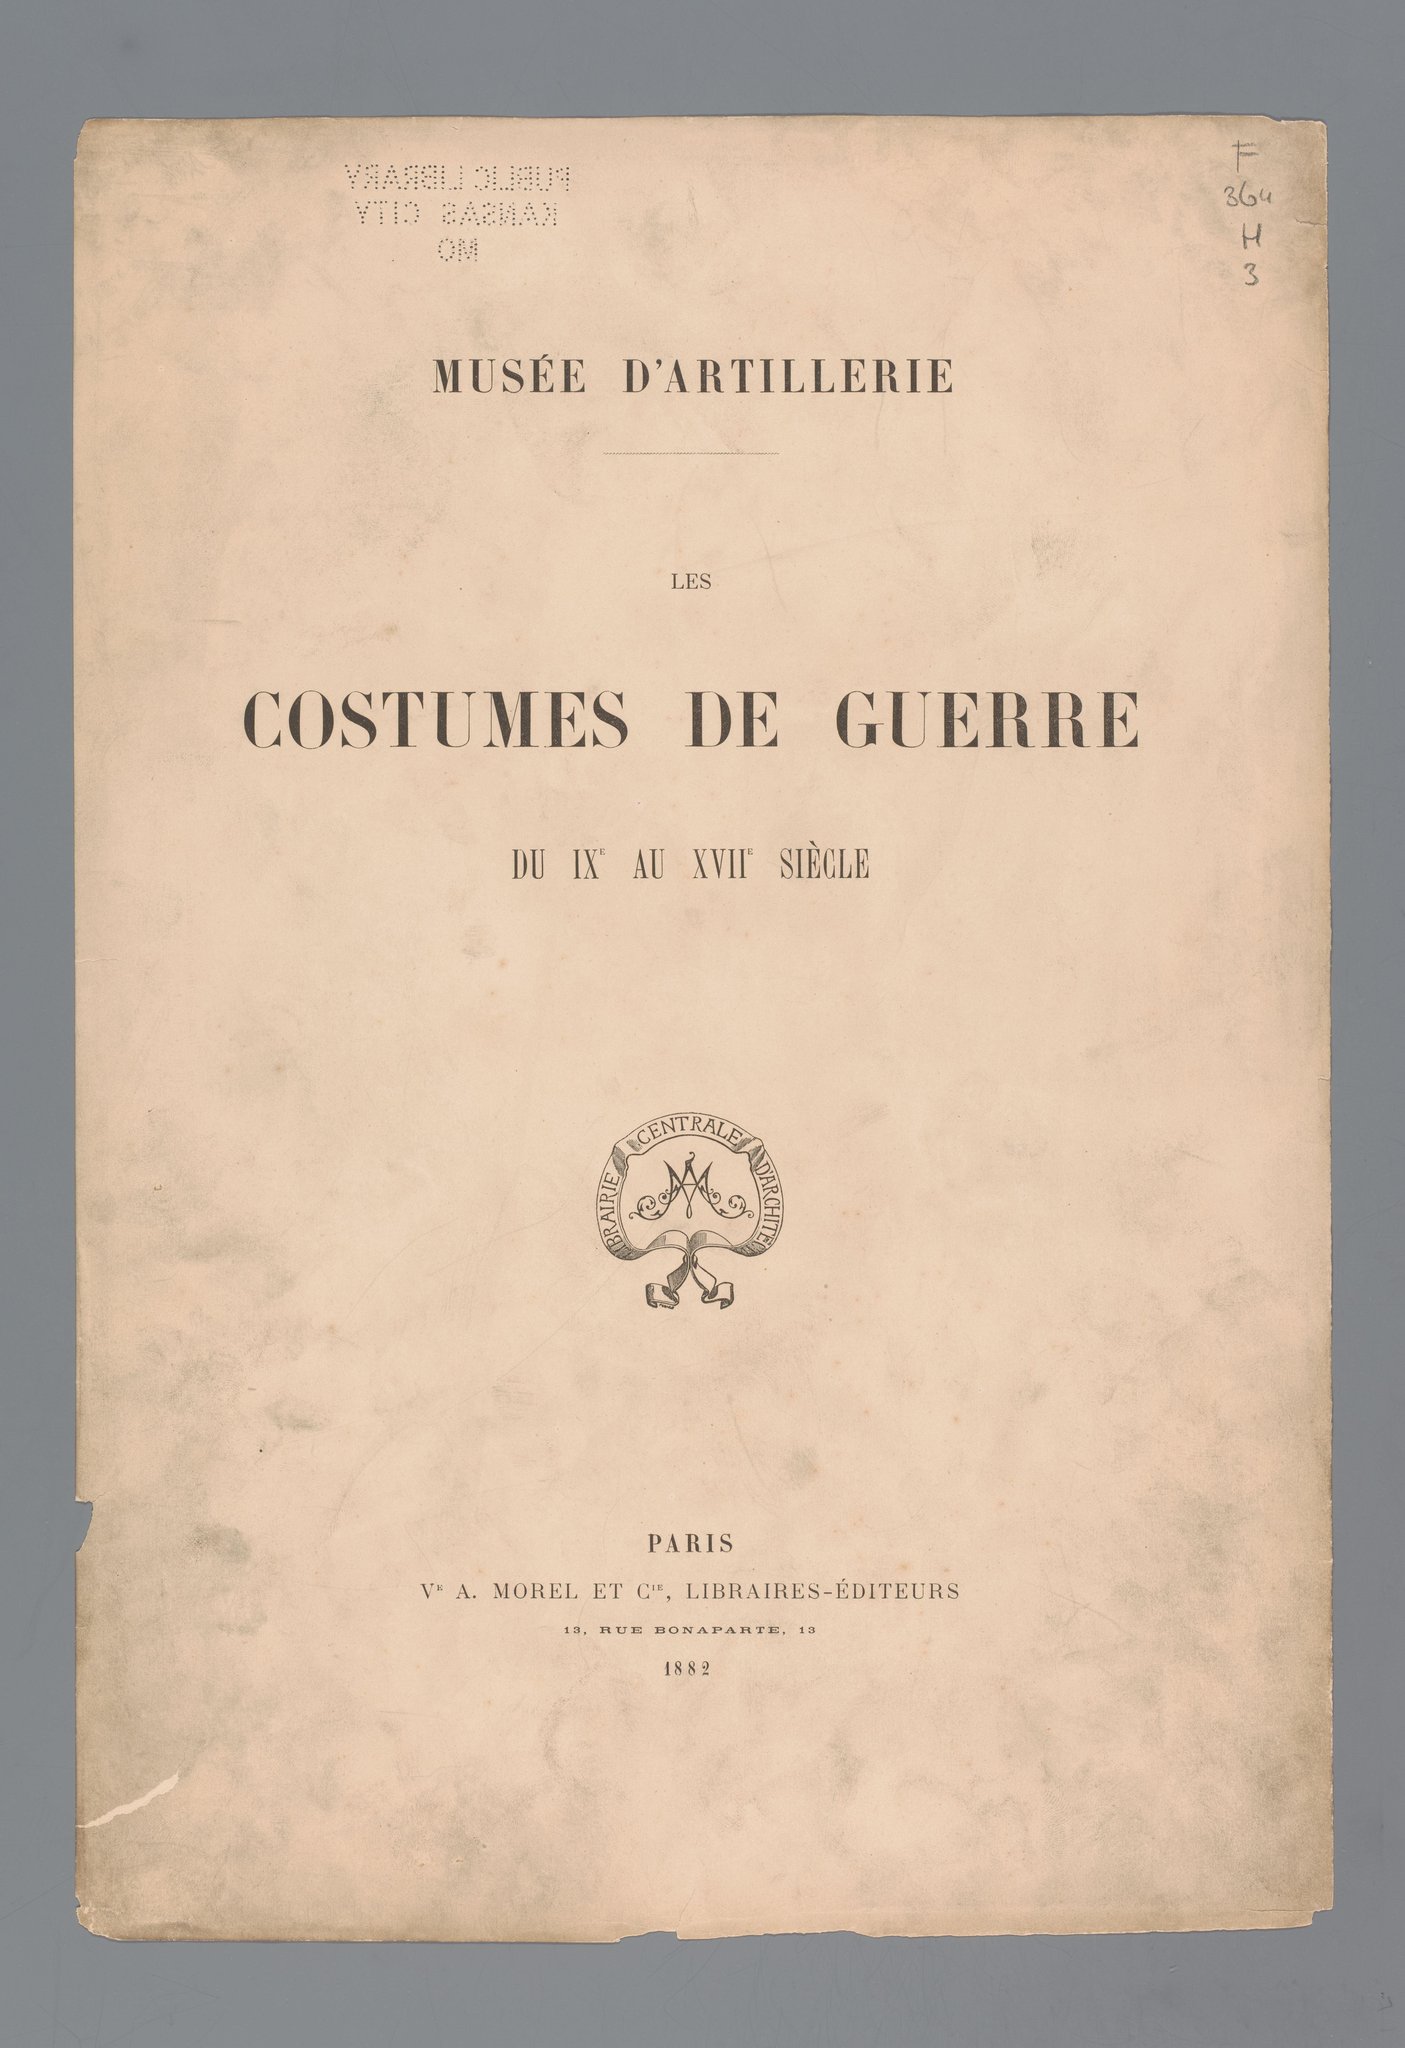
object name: wrapper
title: Les costumes de guerre du IXe aux XVIIe siècle / Musée d'artillerie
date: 1882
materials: cardboard, linen, paper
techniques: printing, woodburytype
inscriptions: bookplate: ‘Kansas City Public Library/ Locked Case/ REFERENCE ROOM/ Flat shelf/ NOT TO BE TAKEN FROM THE ROOM’, date: ‘JUNE/ 1994’, bookplate: ‘reference collection book (...)’, number: ‘399/ C84’, check stamp: ‘PUBLIC LIBRARY/ KANSAS CITY/ MO’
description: Omslag met 36 prenten, een titelblad en een lijst van afbeeldingen.